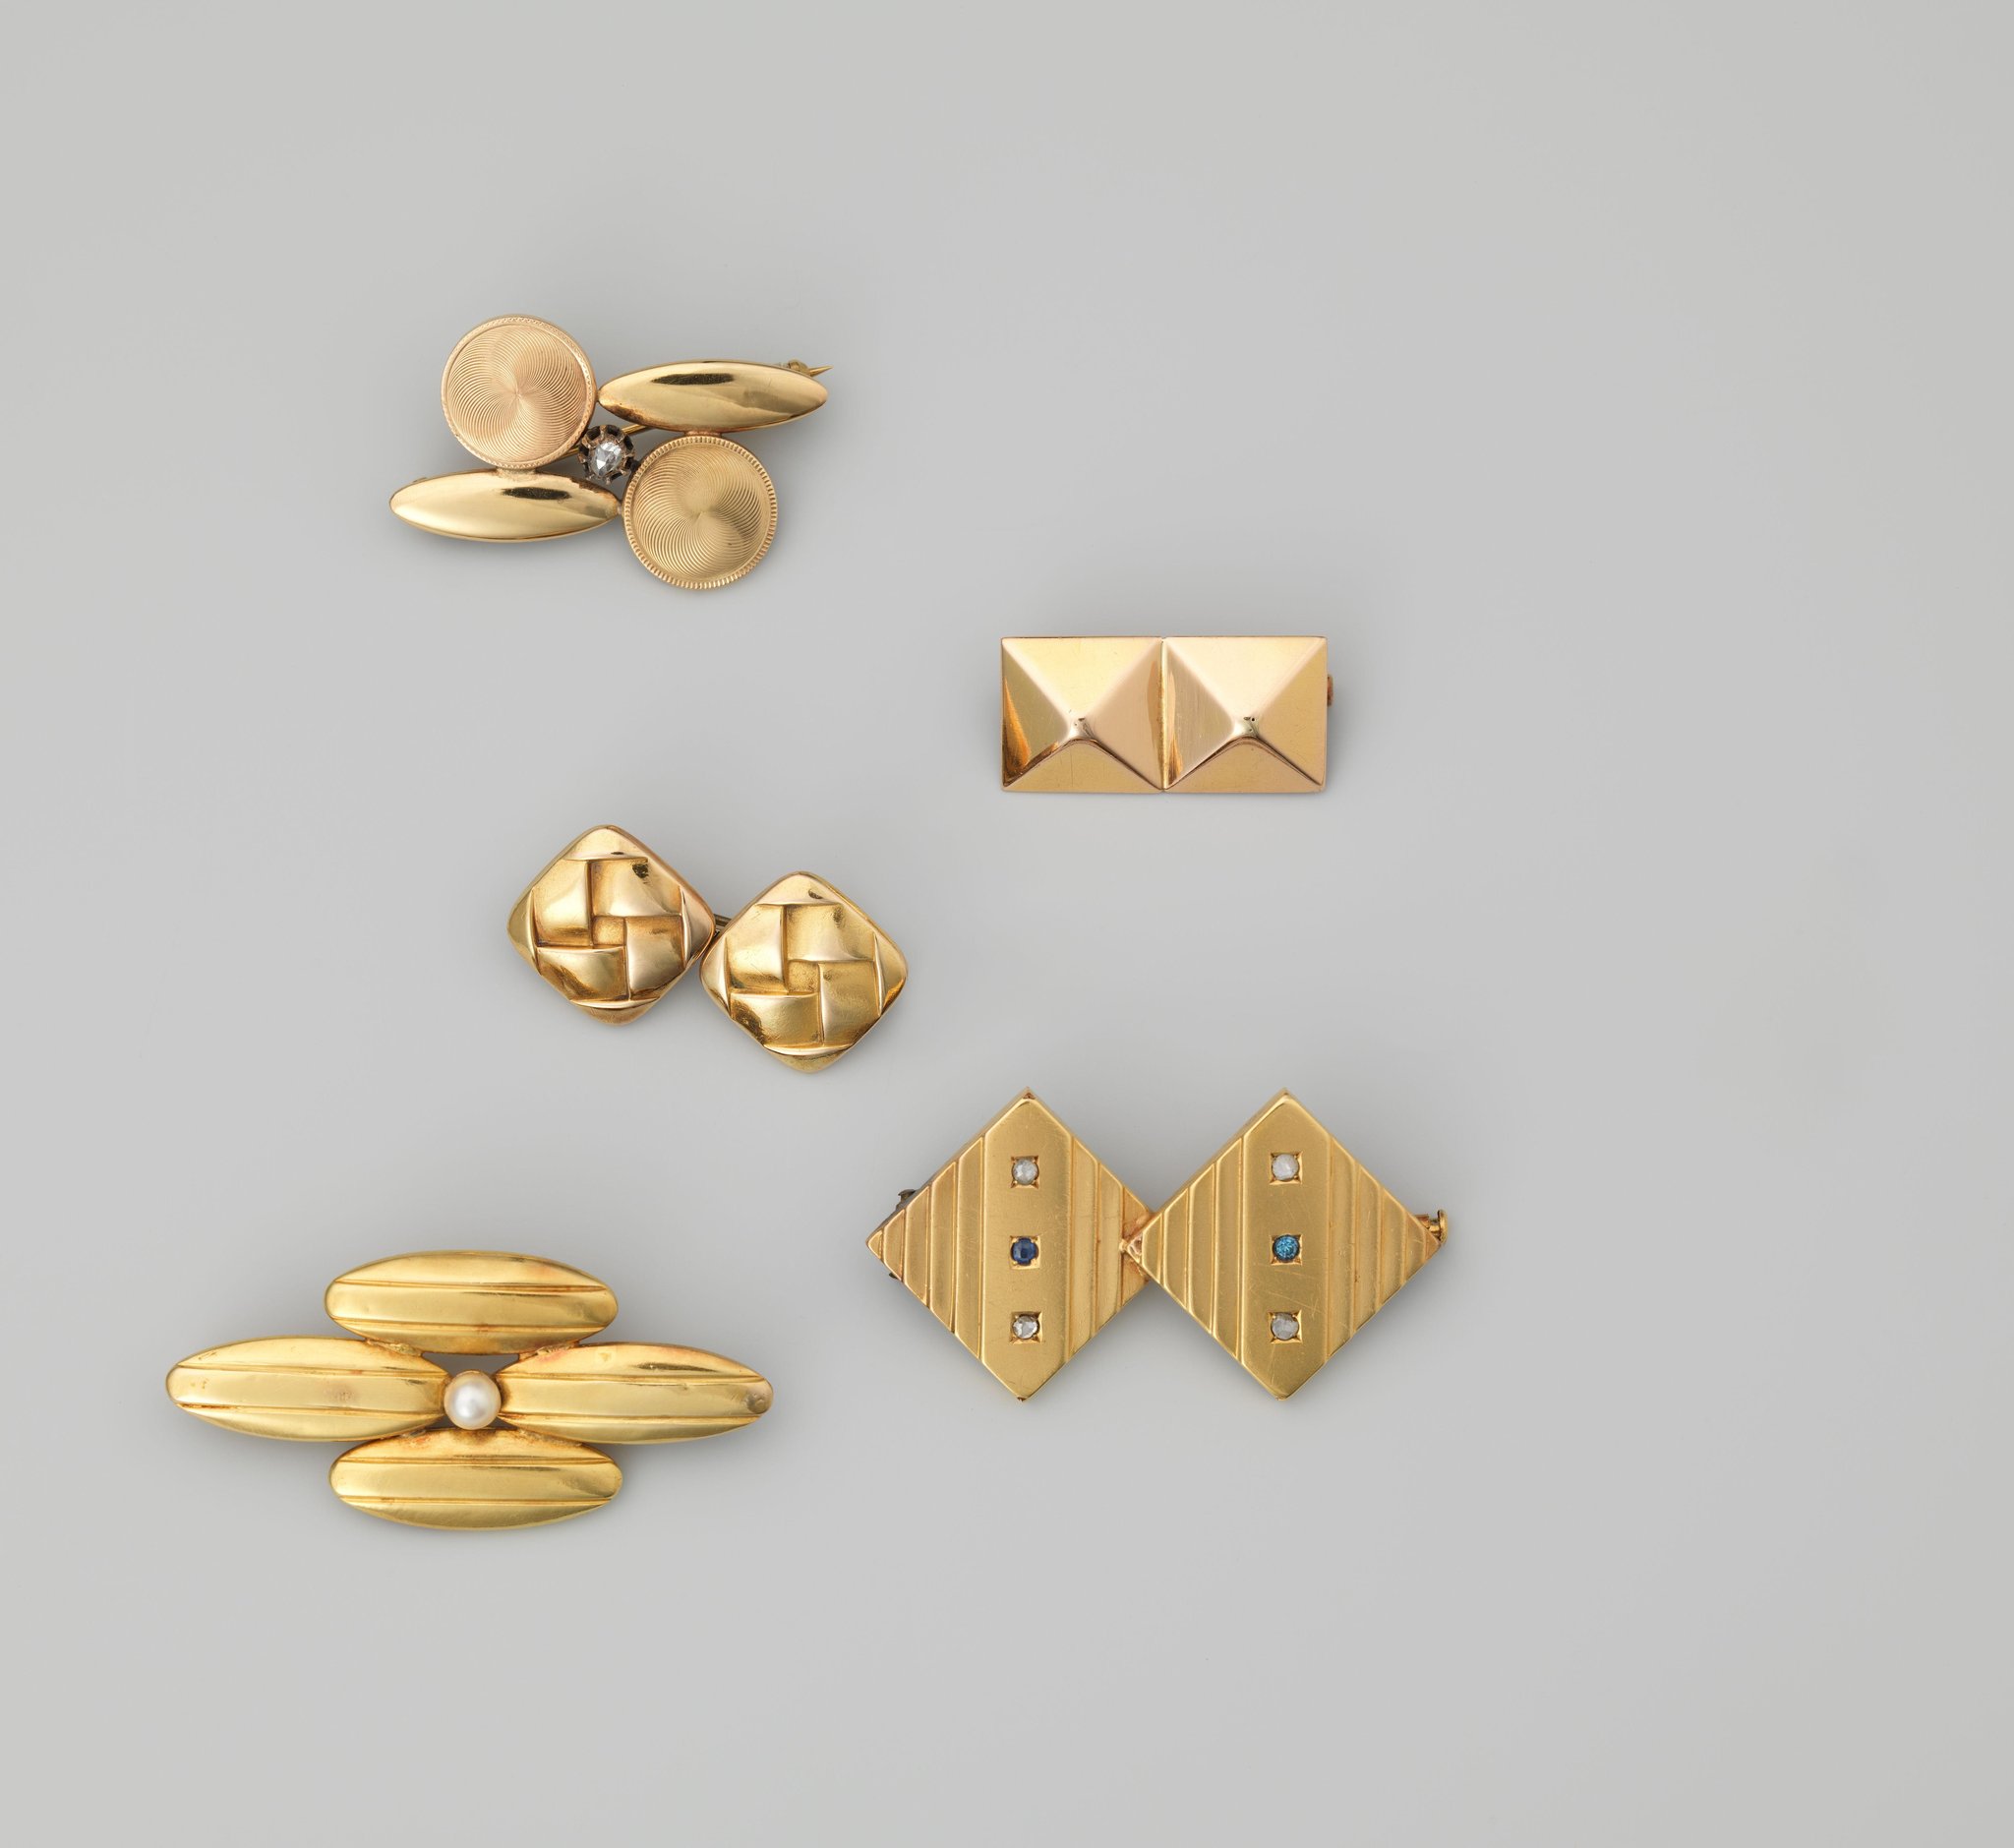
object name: brooch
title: Five Brooches Made of Cufflinks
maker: Anonymous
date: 1930-1960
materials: diamond, gold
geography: netherlands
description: Broche van twee ovale en twee ronde manchetknopen met centraal een kleine roosgeslepen diamant. De broche is voorzien van een kogelsluiting.